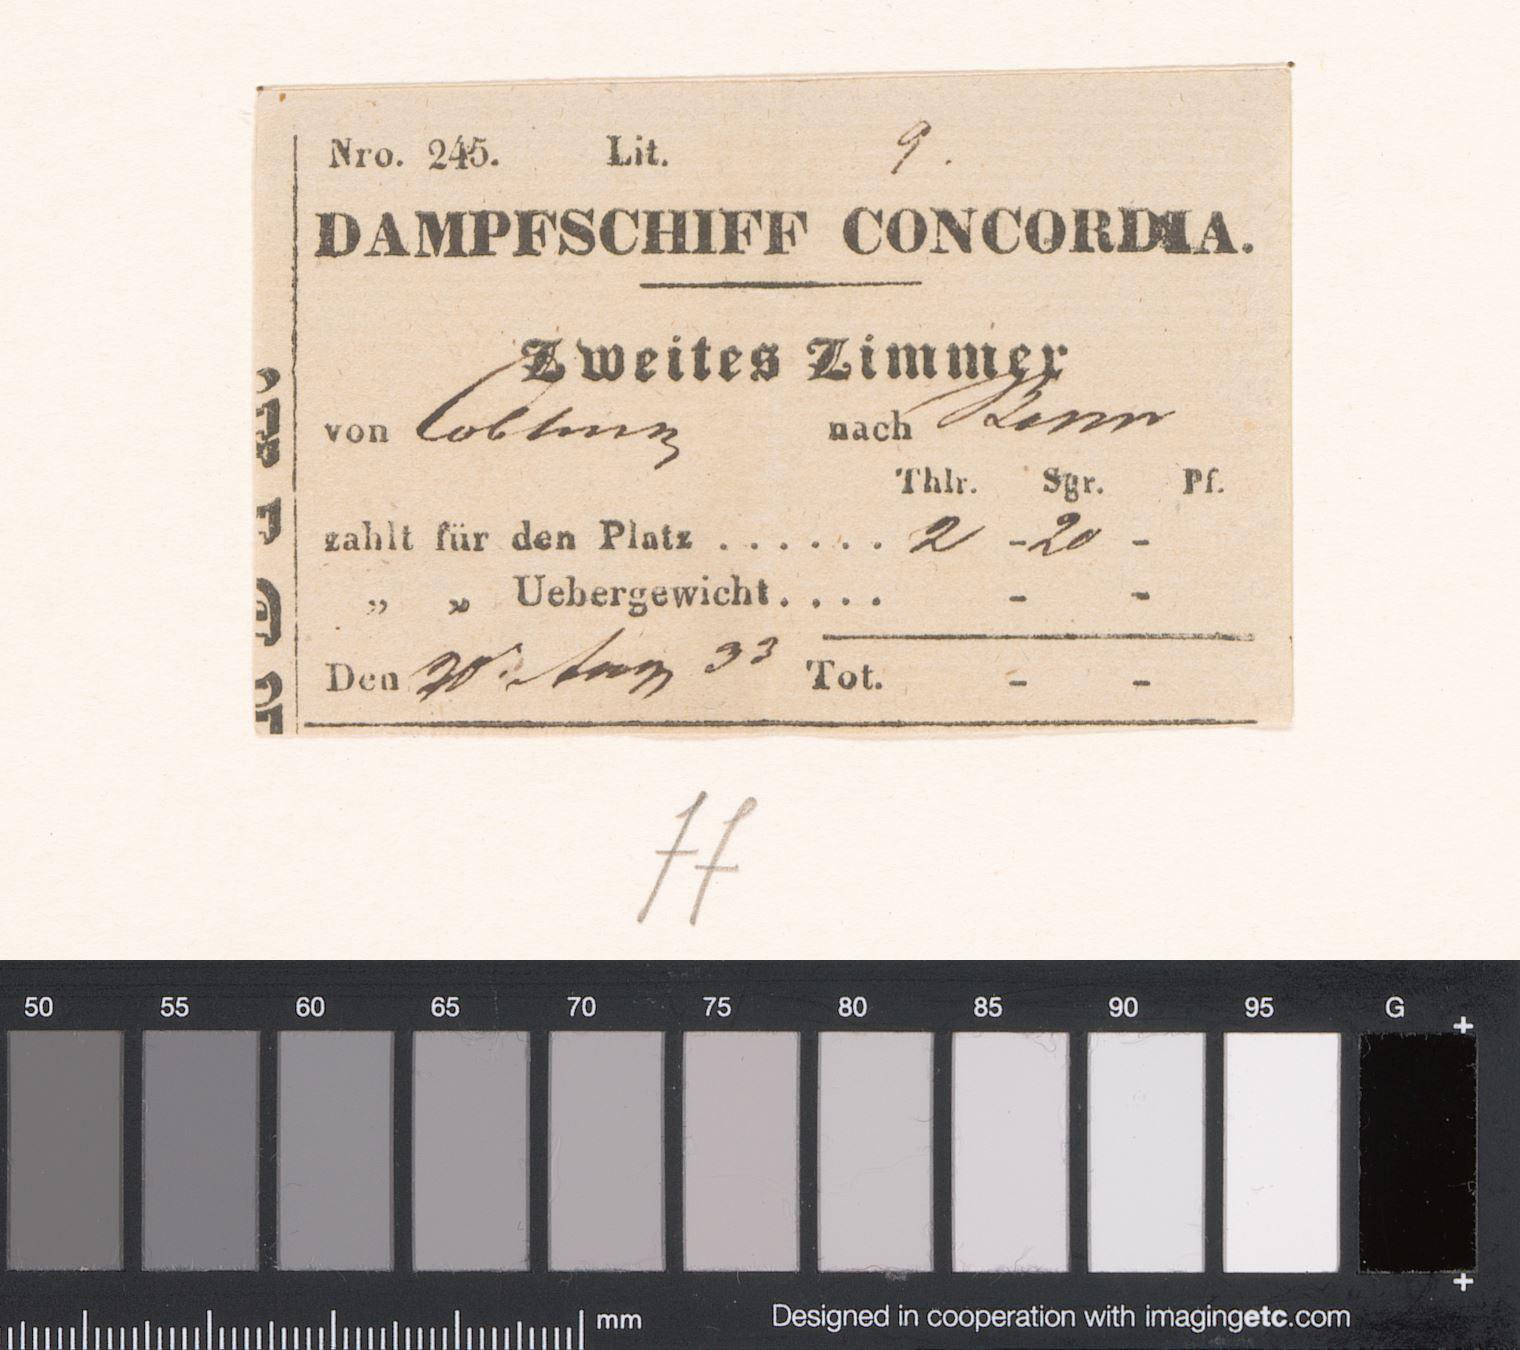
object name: travel document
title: Document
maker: Anonymous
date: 1833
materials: paper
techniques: printing, writing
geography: germany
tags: the hague, johan rudolf thorbecke, germany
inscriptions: date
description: Kaartje Dampschiff Concordia van Coblenz naar Bonn. Gedateerd: 20 aug. 1833.